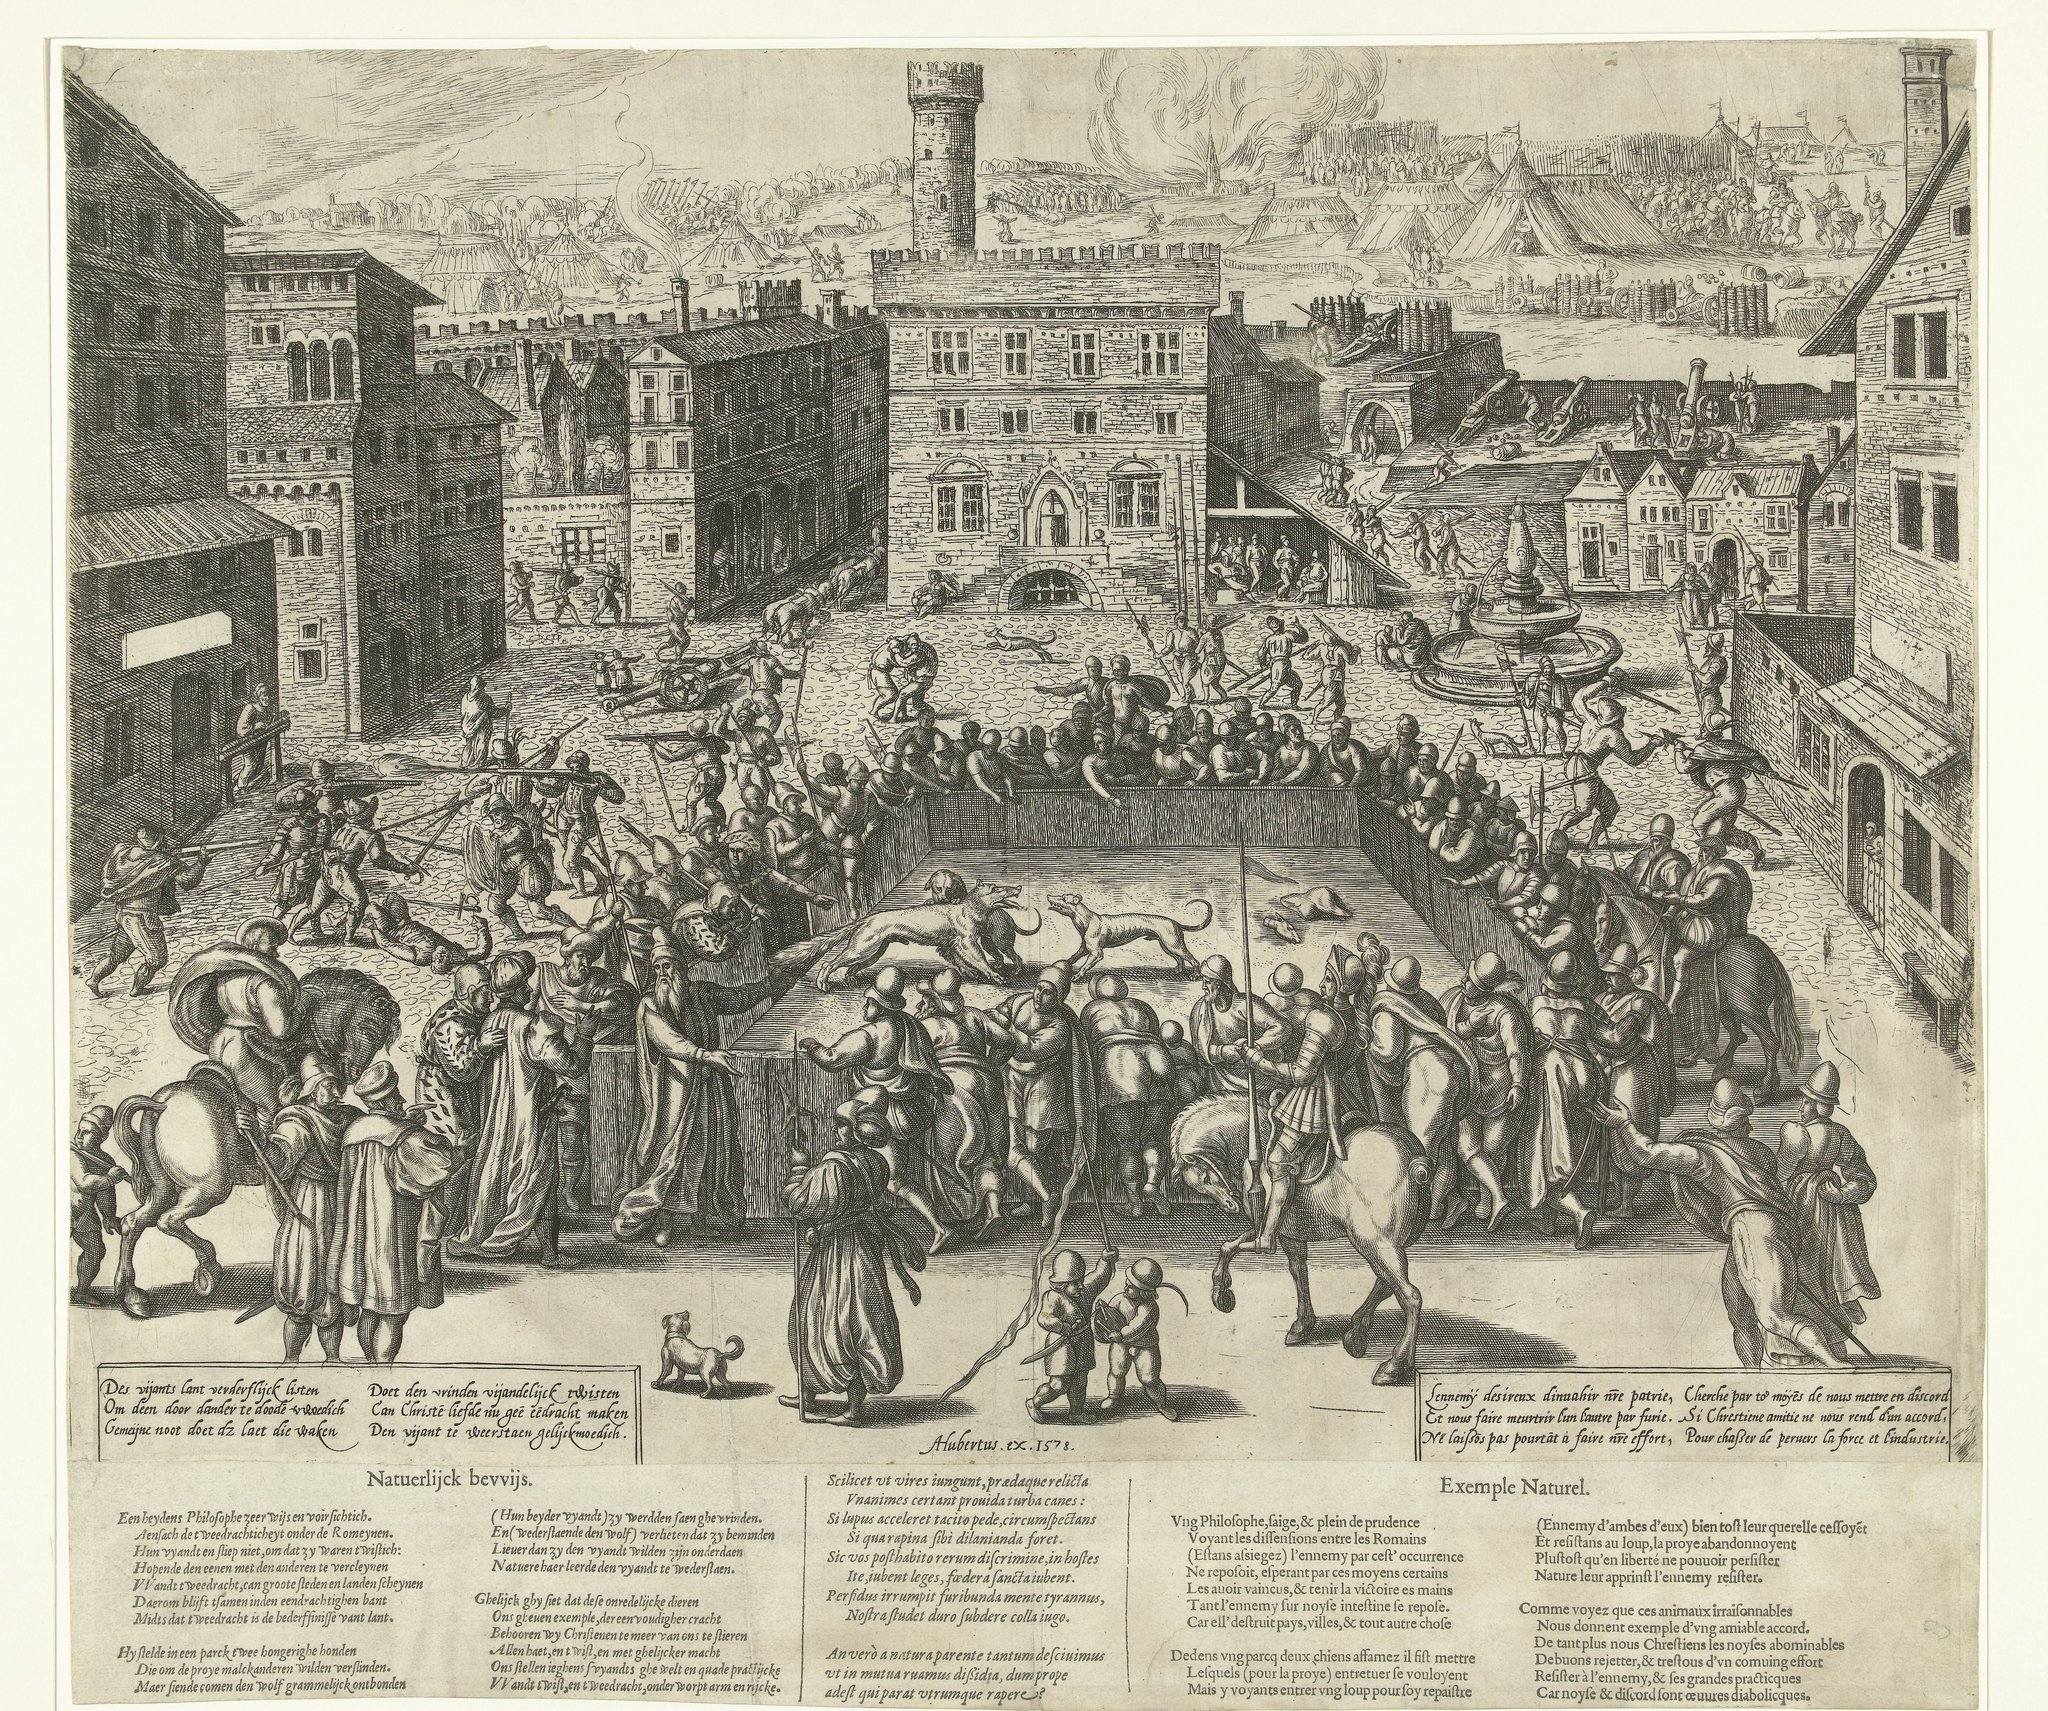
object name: propagandaprent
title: Oproep tot eendracht in de Nederlanden, 1578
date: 1578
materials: paper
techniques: engraving, etching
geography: low countries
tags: tormenting mammals ~ sport and recreation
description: Politieke allegorie waarin opgeroepen wordt tot eendrachtig optreden van de Nederlanden tegen de Spaanse vijand. Op een Romeins (of Italiaans) stadsplein vindt binnen een omheining een gevecht plaats tussen twee honden en een wolf. Rondom de arena een grote groep toeschouwers. Op de voorgrond geeft een man uitleg over de politieke interpretatie van de gebeurtenis en de betekenis ervan. De stad wordt belegerd, op de achtergrond het legerkamp van de belegeraars. Onderaan de plaat twee cartouches met gegraveerde teksten van zes regels in het Nederlands en Frans. Vastgeplakt onder de prent een blad met teksten in het Nederlands, Latijn en Frans.